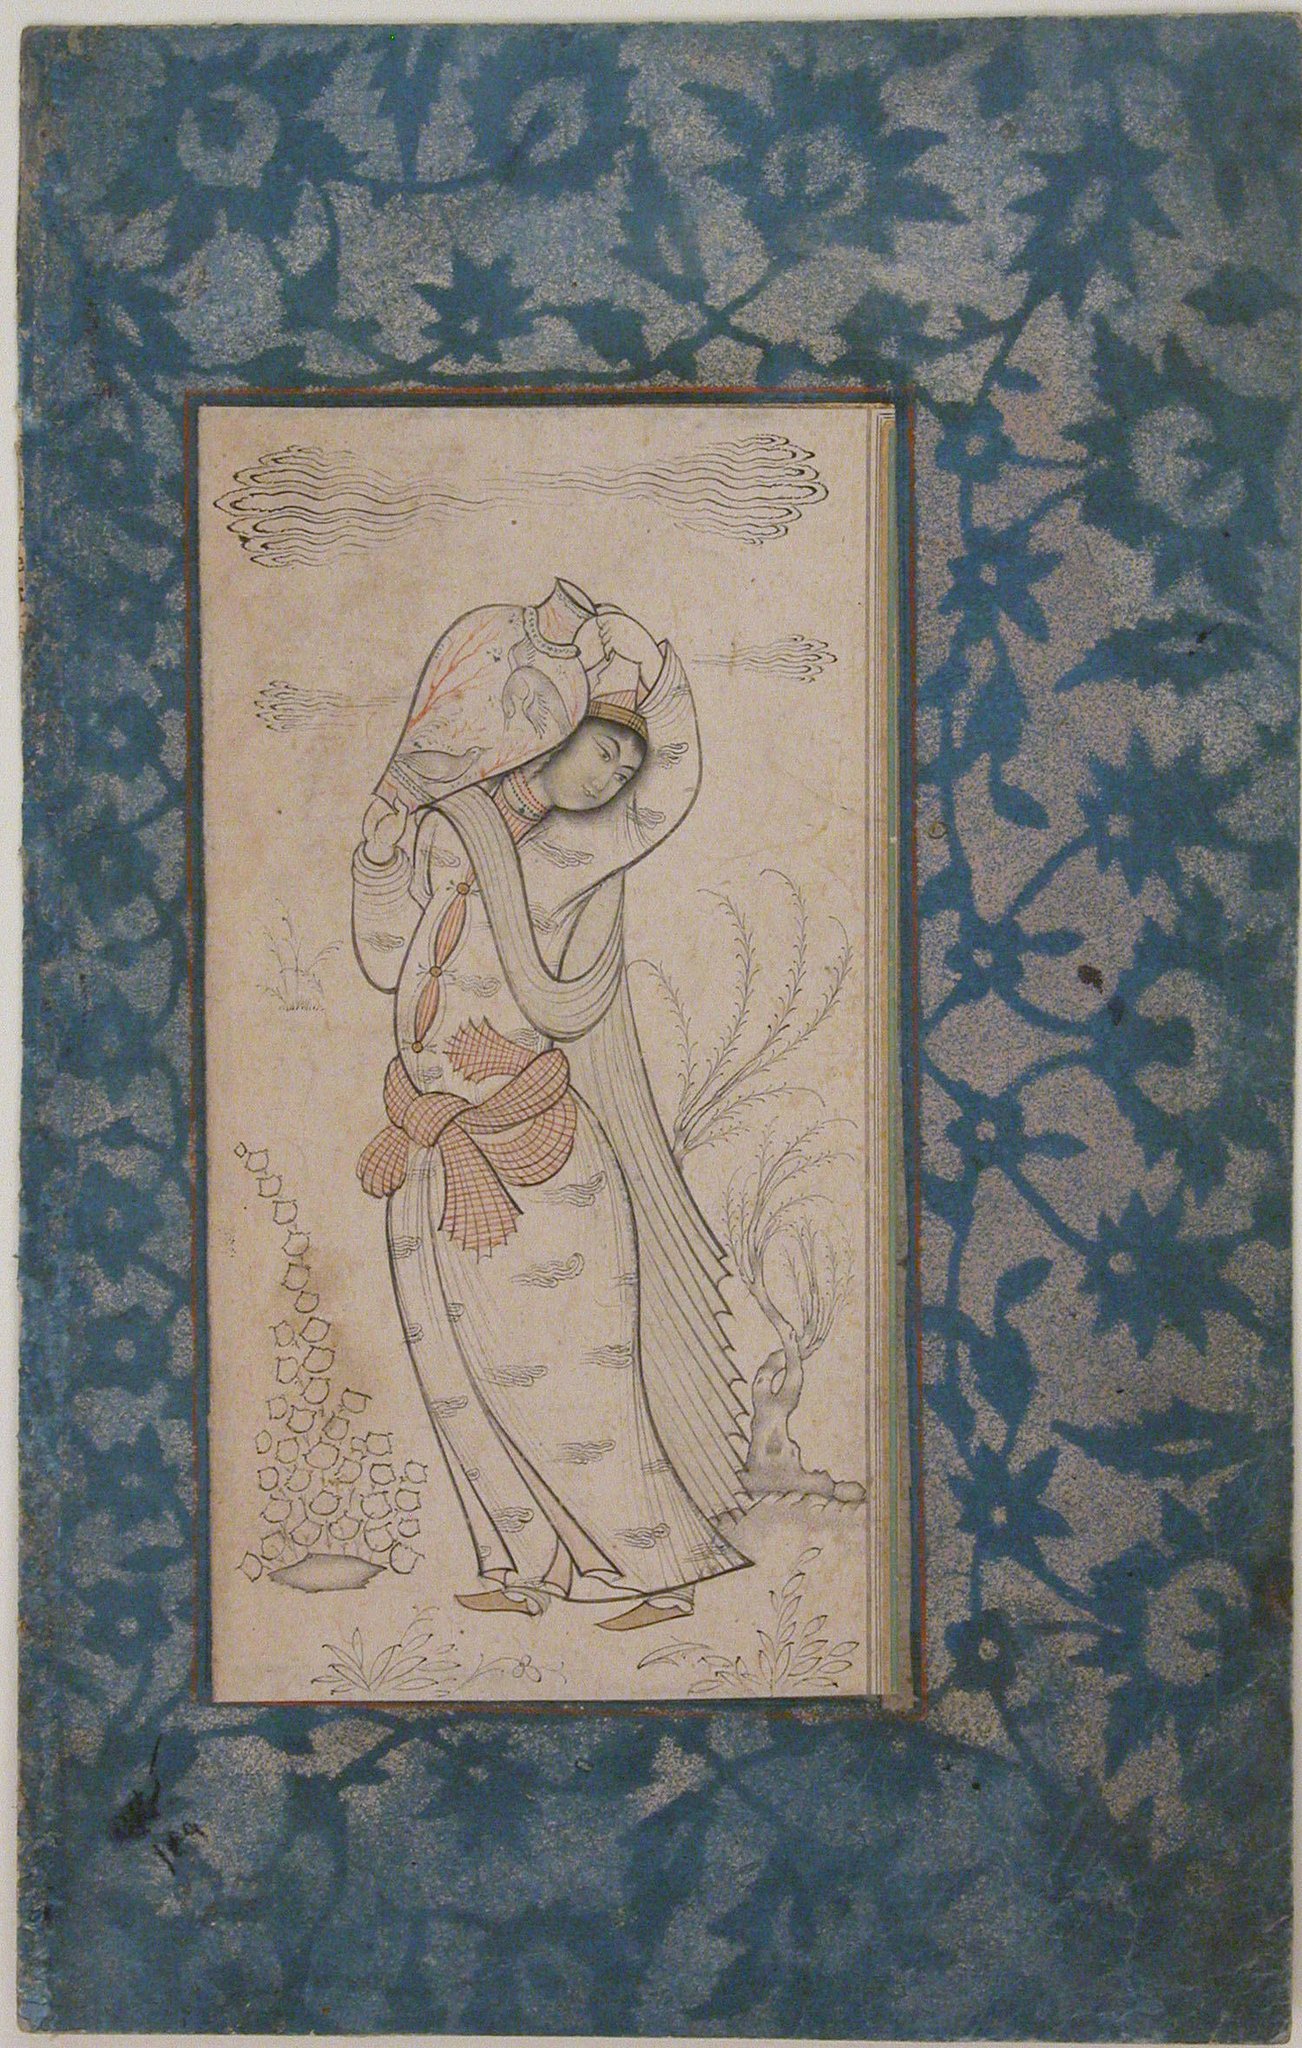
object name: illustrated single work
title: Woman Carrying a Vase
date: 1601-1700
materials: gold, ink, paper, watercolor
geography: iran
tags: women